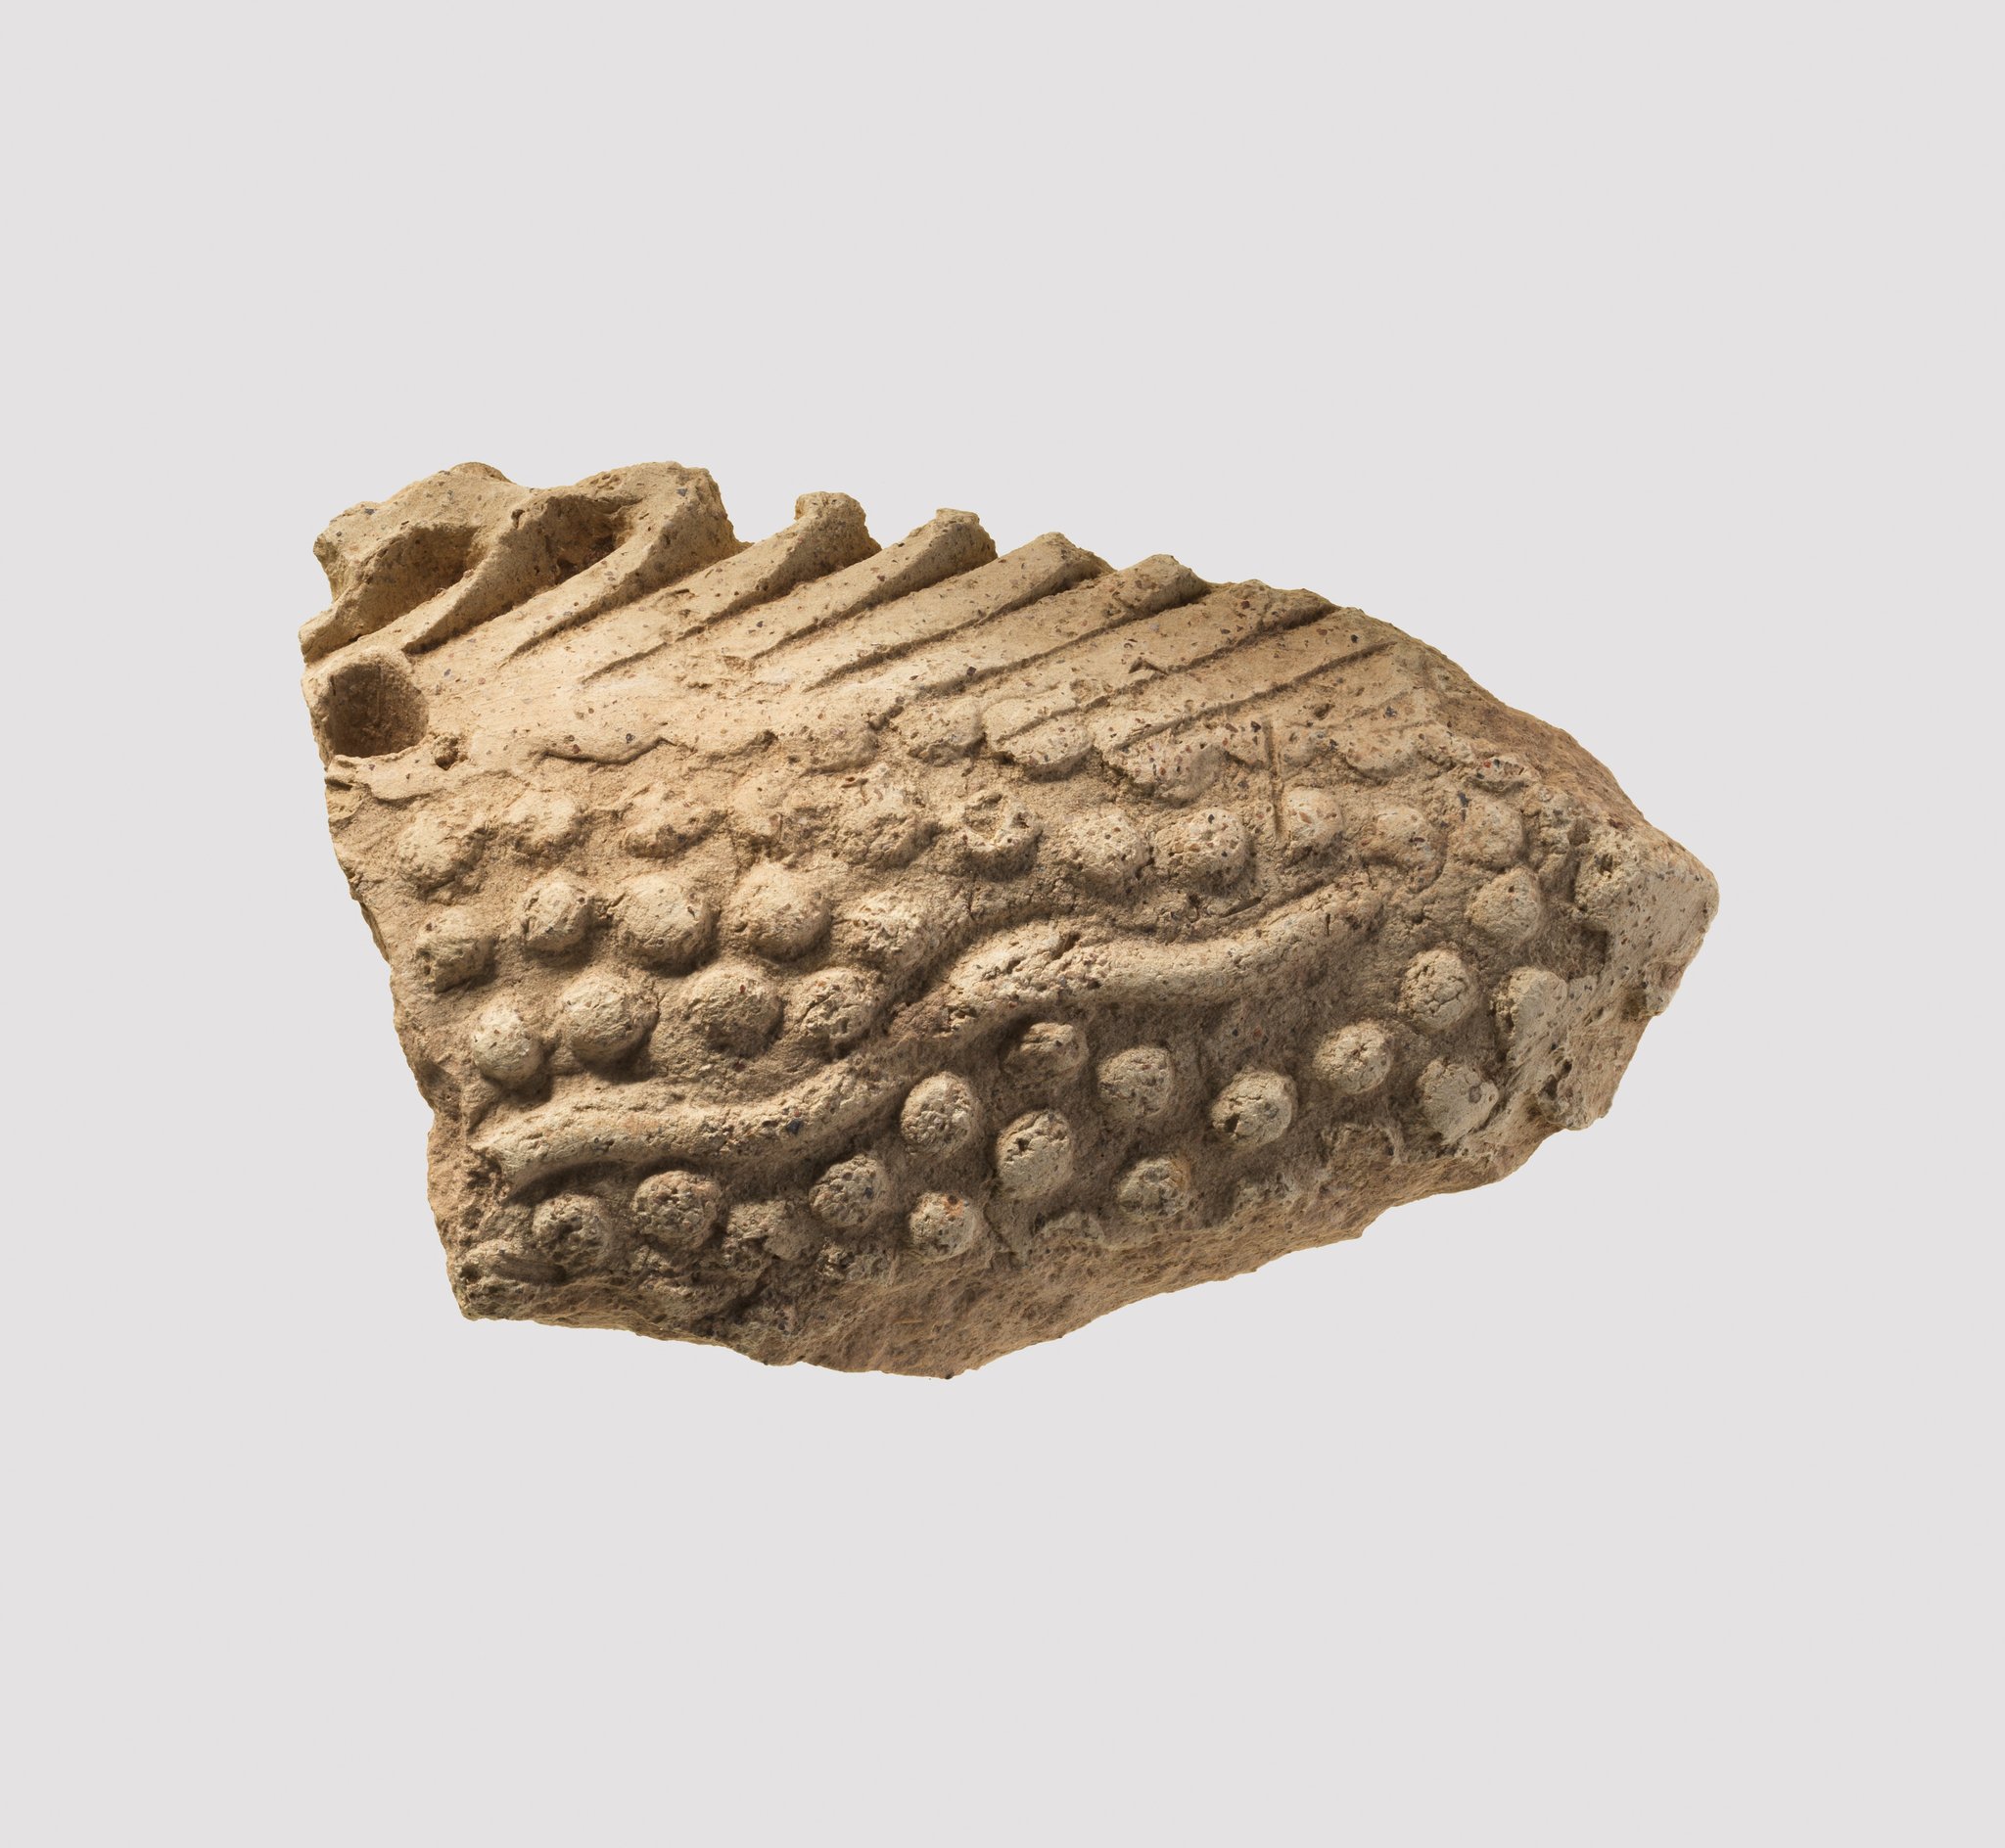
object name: sherd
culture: sasanian or islamic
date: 501-700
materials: ceramic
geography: mesopotamia